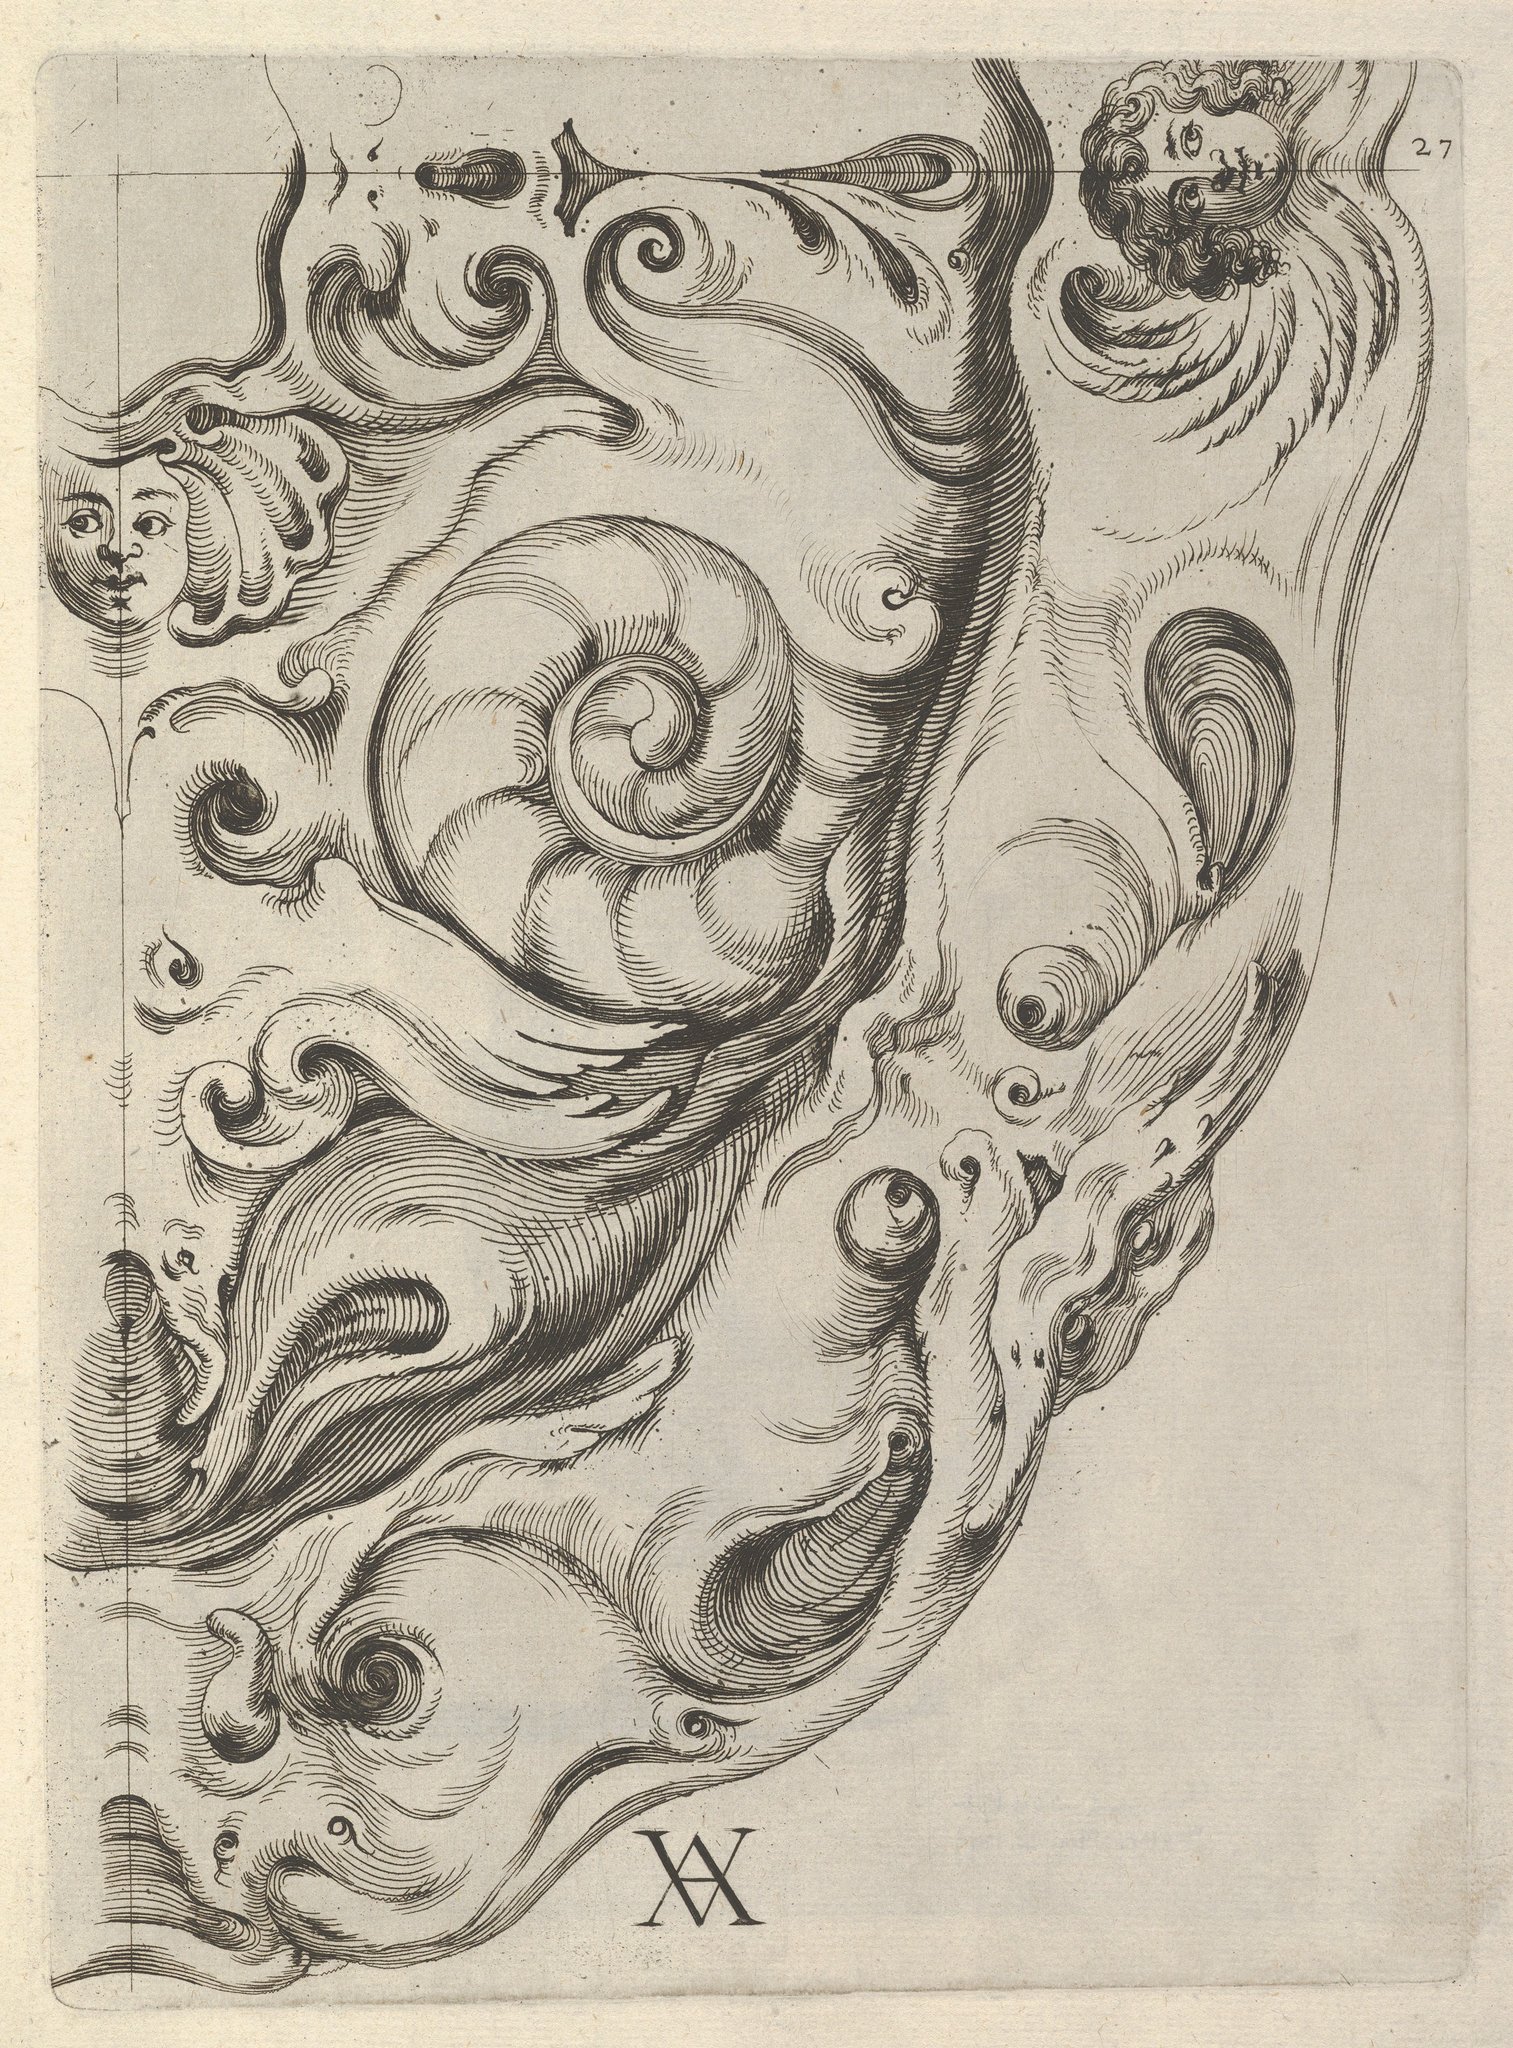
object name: album print ornament architecture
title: Plate 27, from "Modelli Artificiosi (...), parte seconda"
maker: theodor van kessel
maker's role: etcher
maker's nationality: dutch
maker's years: 1620-1660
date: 1646-1652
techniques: etching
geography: netherlands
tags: ornament